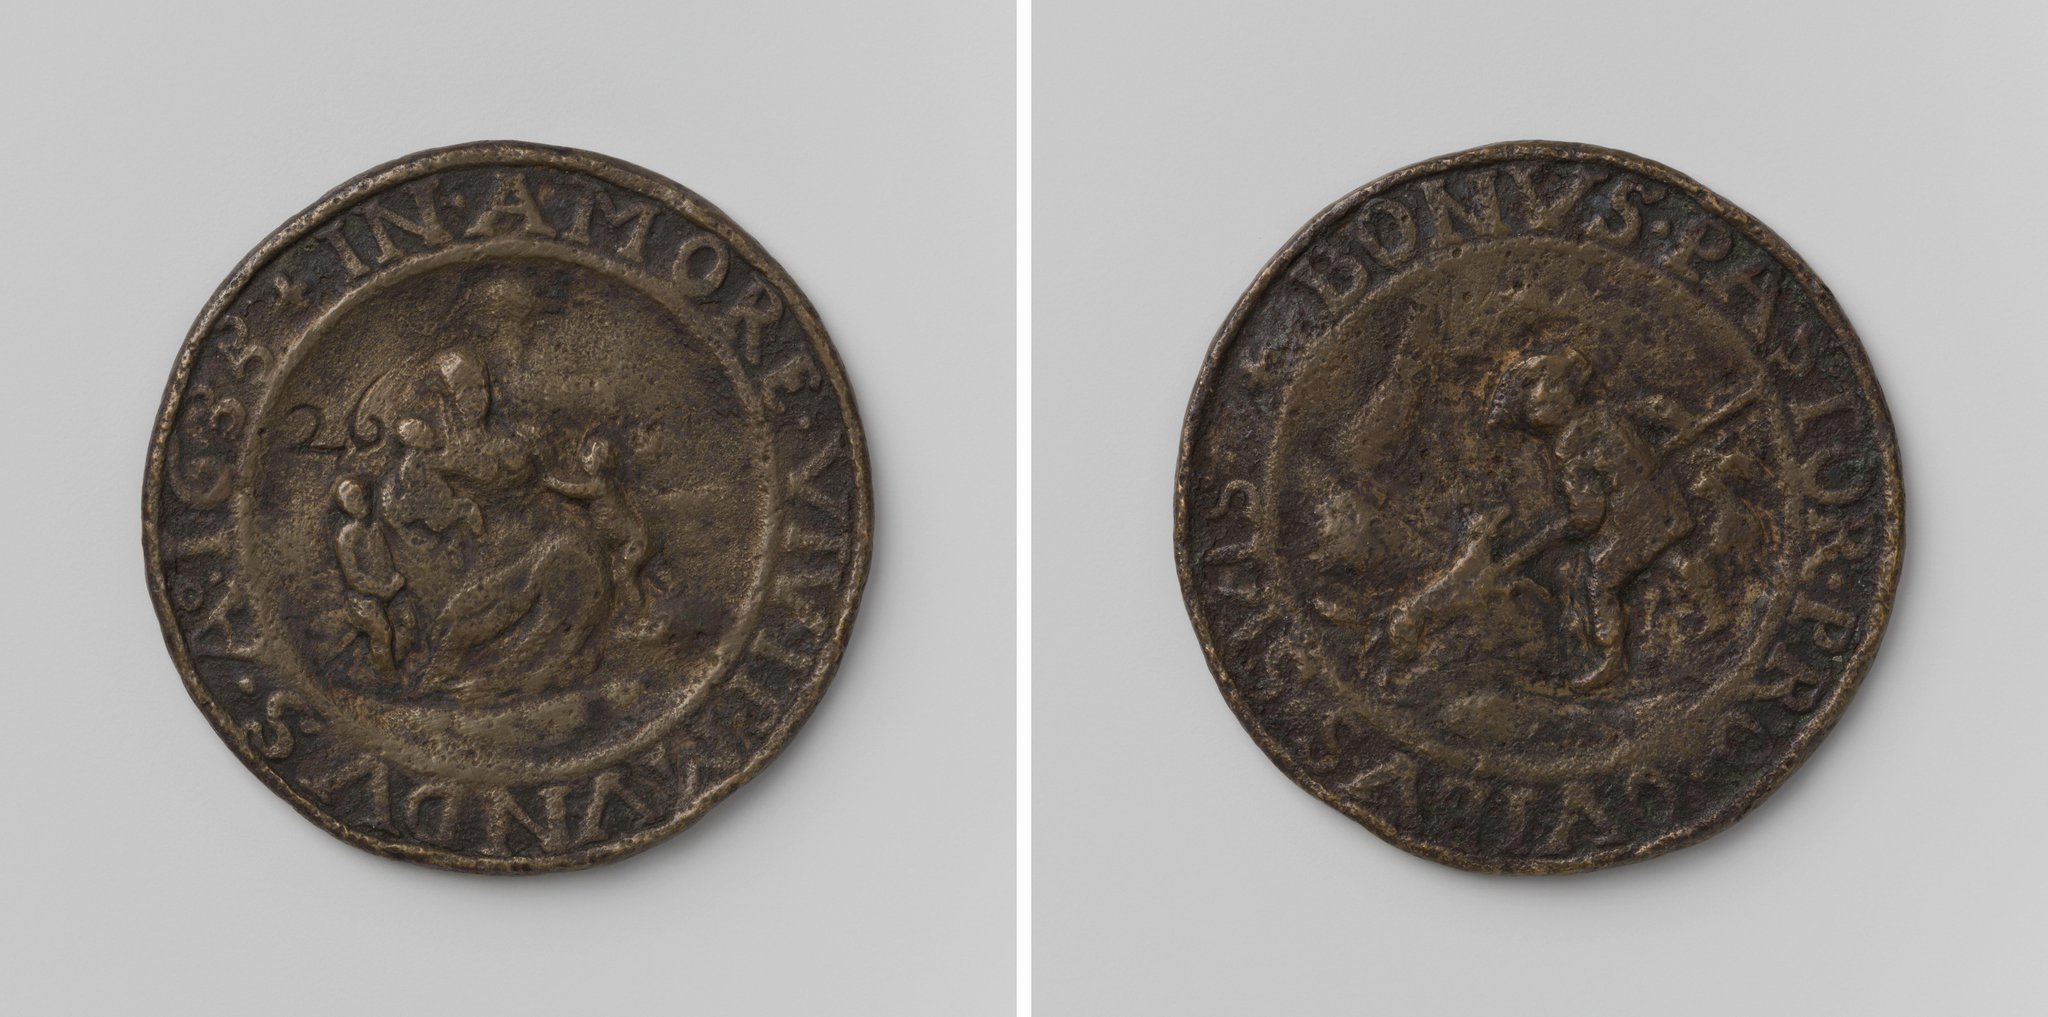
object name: buurtpenning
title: Onbekende buurt te 's-Gravenhage, buurtpenning met no. 26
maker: Anonymous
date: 1655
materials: brass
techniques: casting, engraving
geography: the hague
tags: the hague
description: Messing penning. Voorzijde: zittende vrouw met drie kinderen; links boven: cijfer 26 binnen omschrift. Keerzijde: herder met hoed op hoofd houdt met stok wolf van zijn kudde vandaan binnen omschrift